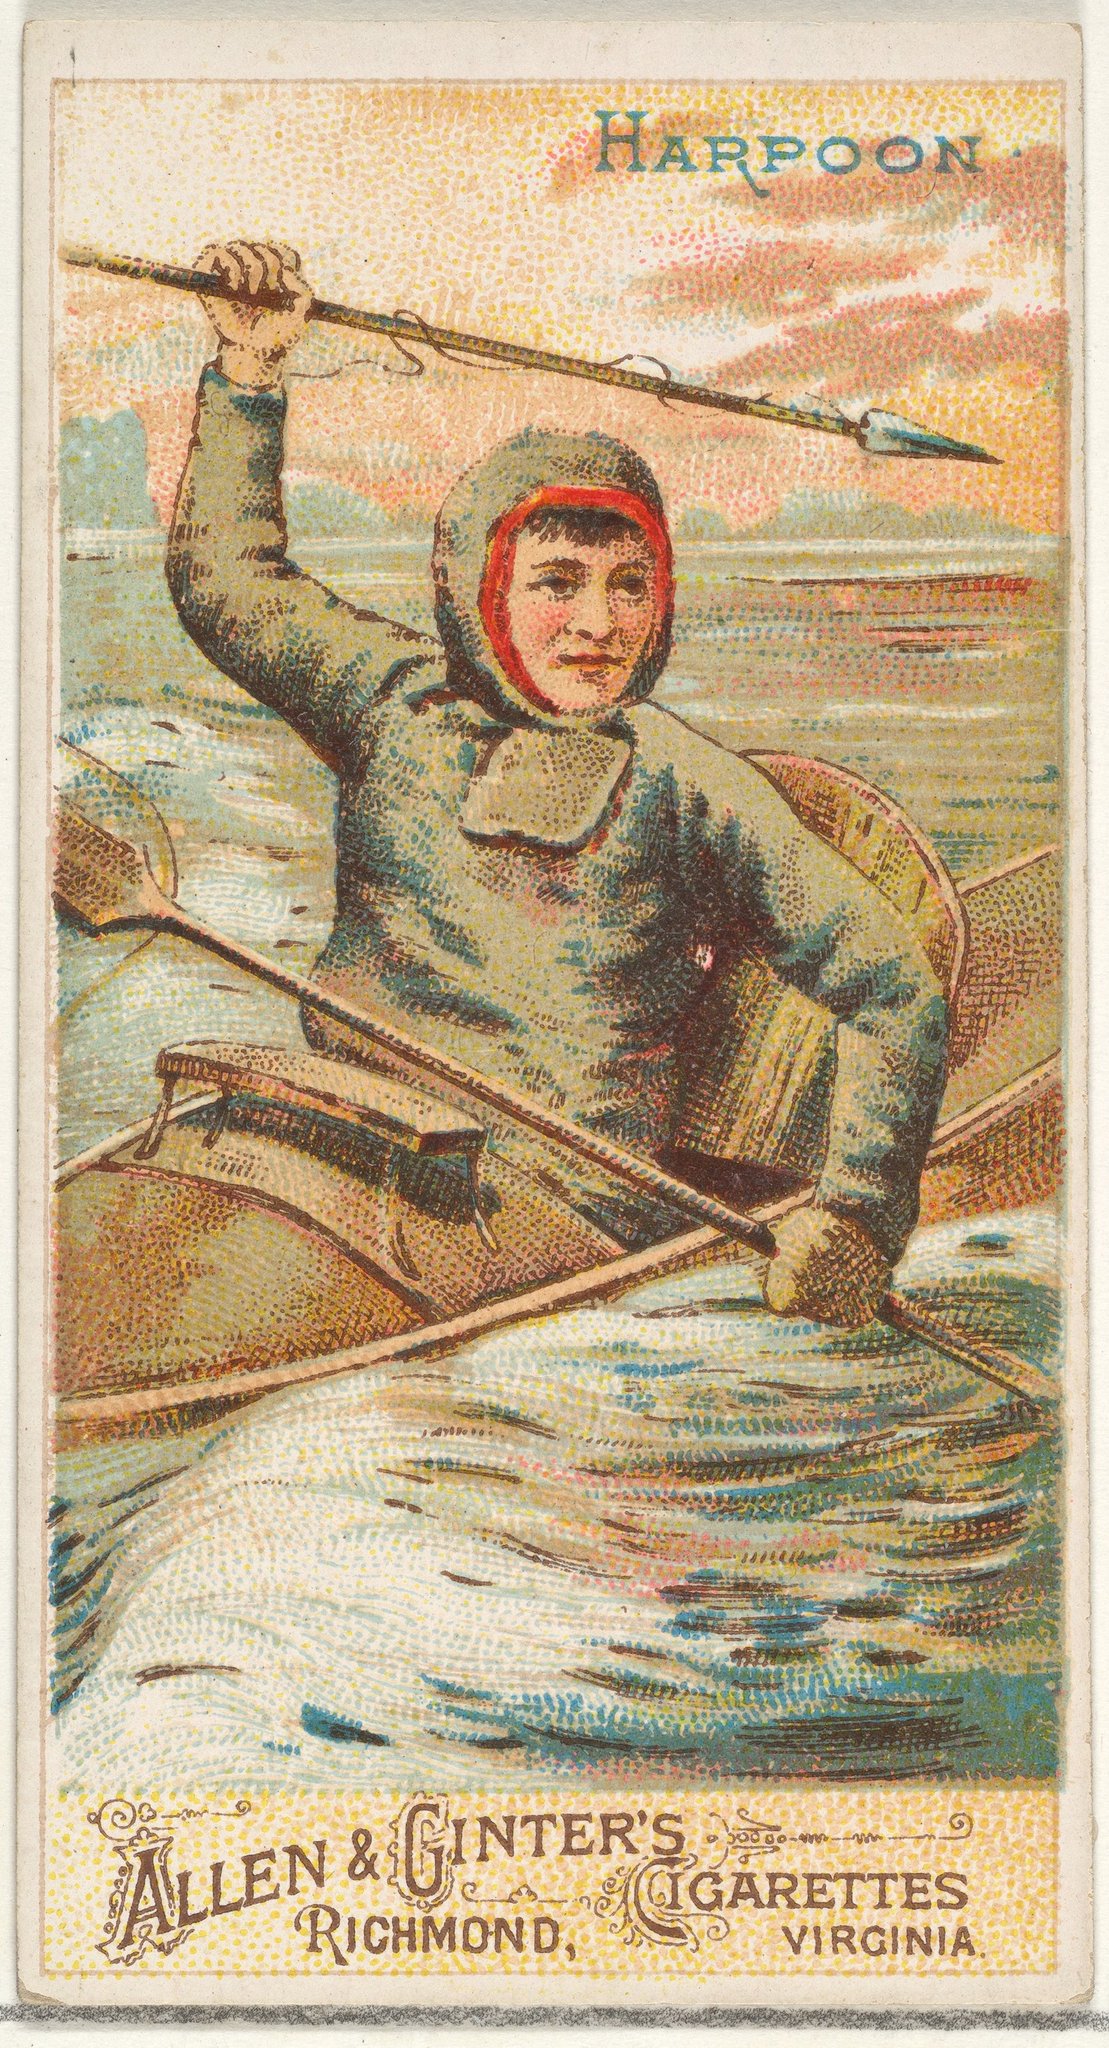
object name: print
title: Harpoon, from the Arms of All Nations series (N3) for Allen & Ginter Cigarettes Brands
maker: allen & ginter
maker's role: publisher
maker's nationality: american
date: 1887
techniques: color lithograph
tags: spears,men,boats